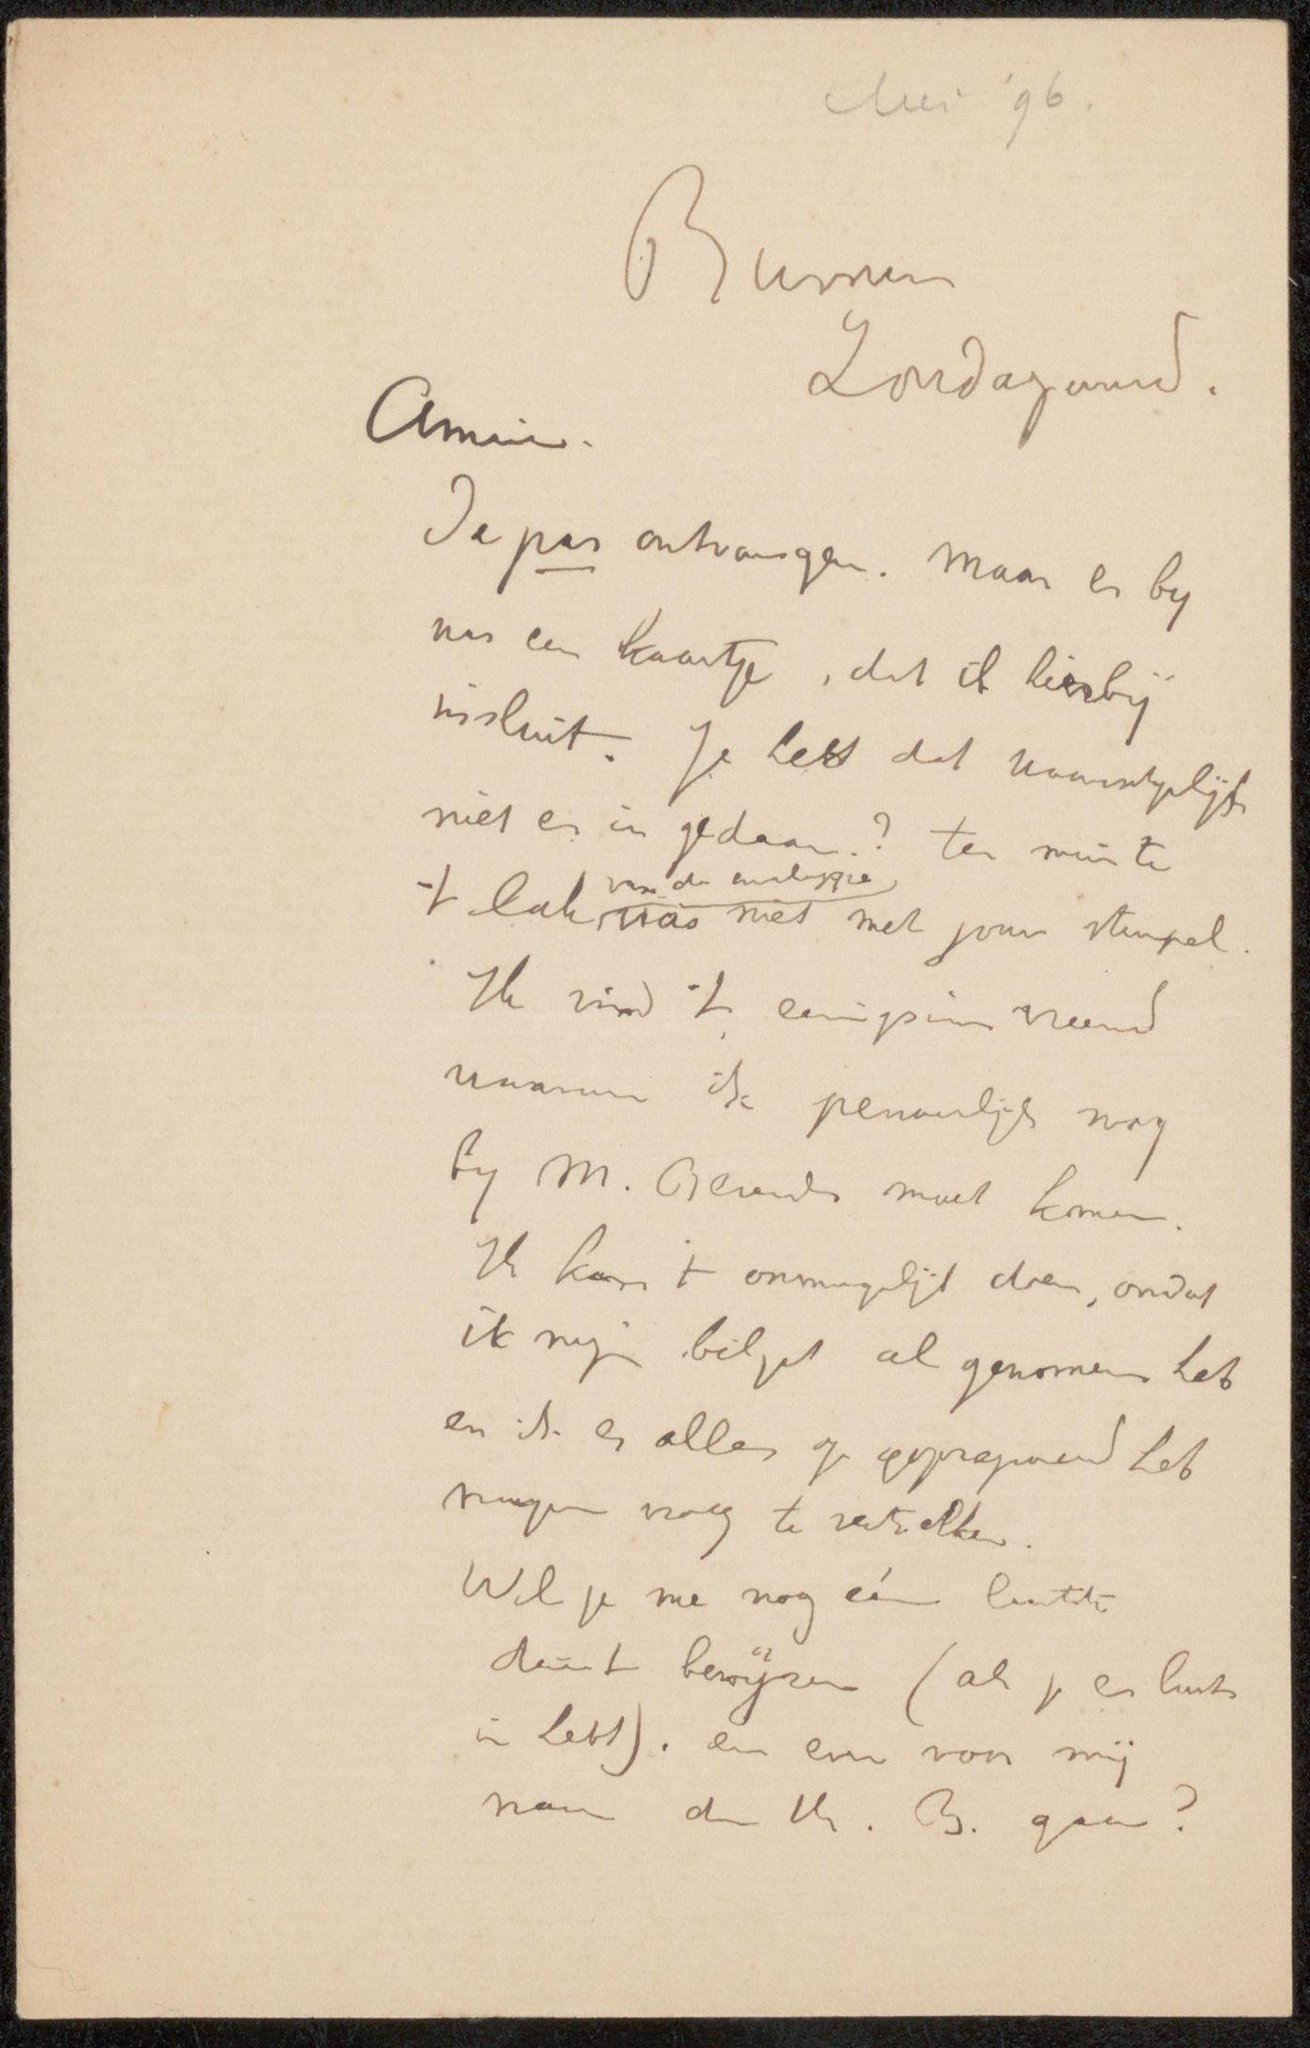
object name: letter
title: Brief aan Philip Zilcken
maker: marius bauer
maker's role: draughtsman, print maker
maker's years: 1867-1932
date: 1877-1932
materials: ink, paper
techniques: pen, writing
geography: bussum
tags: klaas groesbeek, the hague, painter, draughtsman, philip zilcken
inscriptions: collector's mark: ‘RPK’